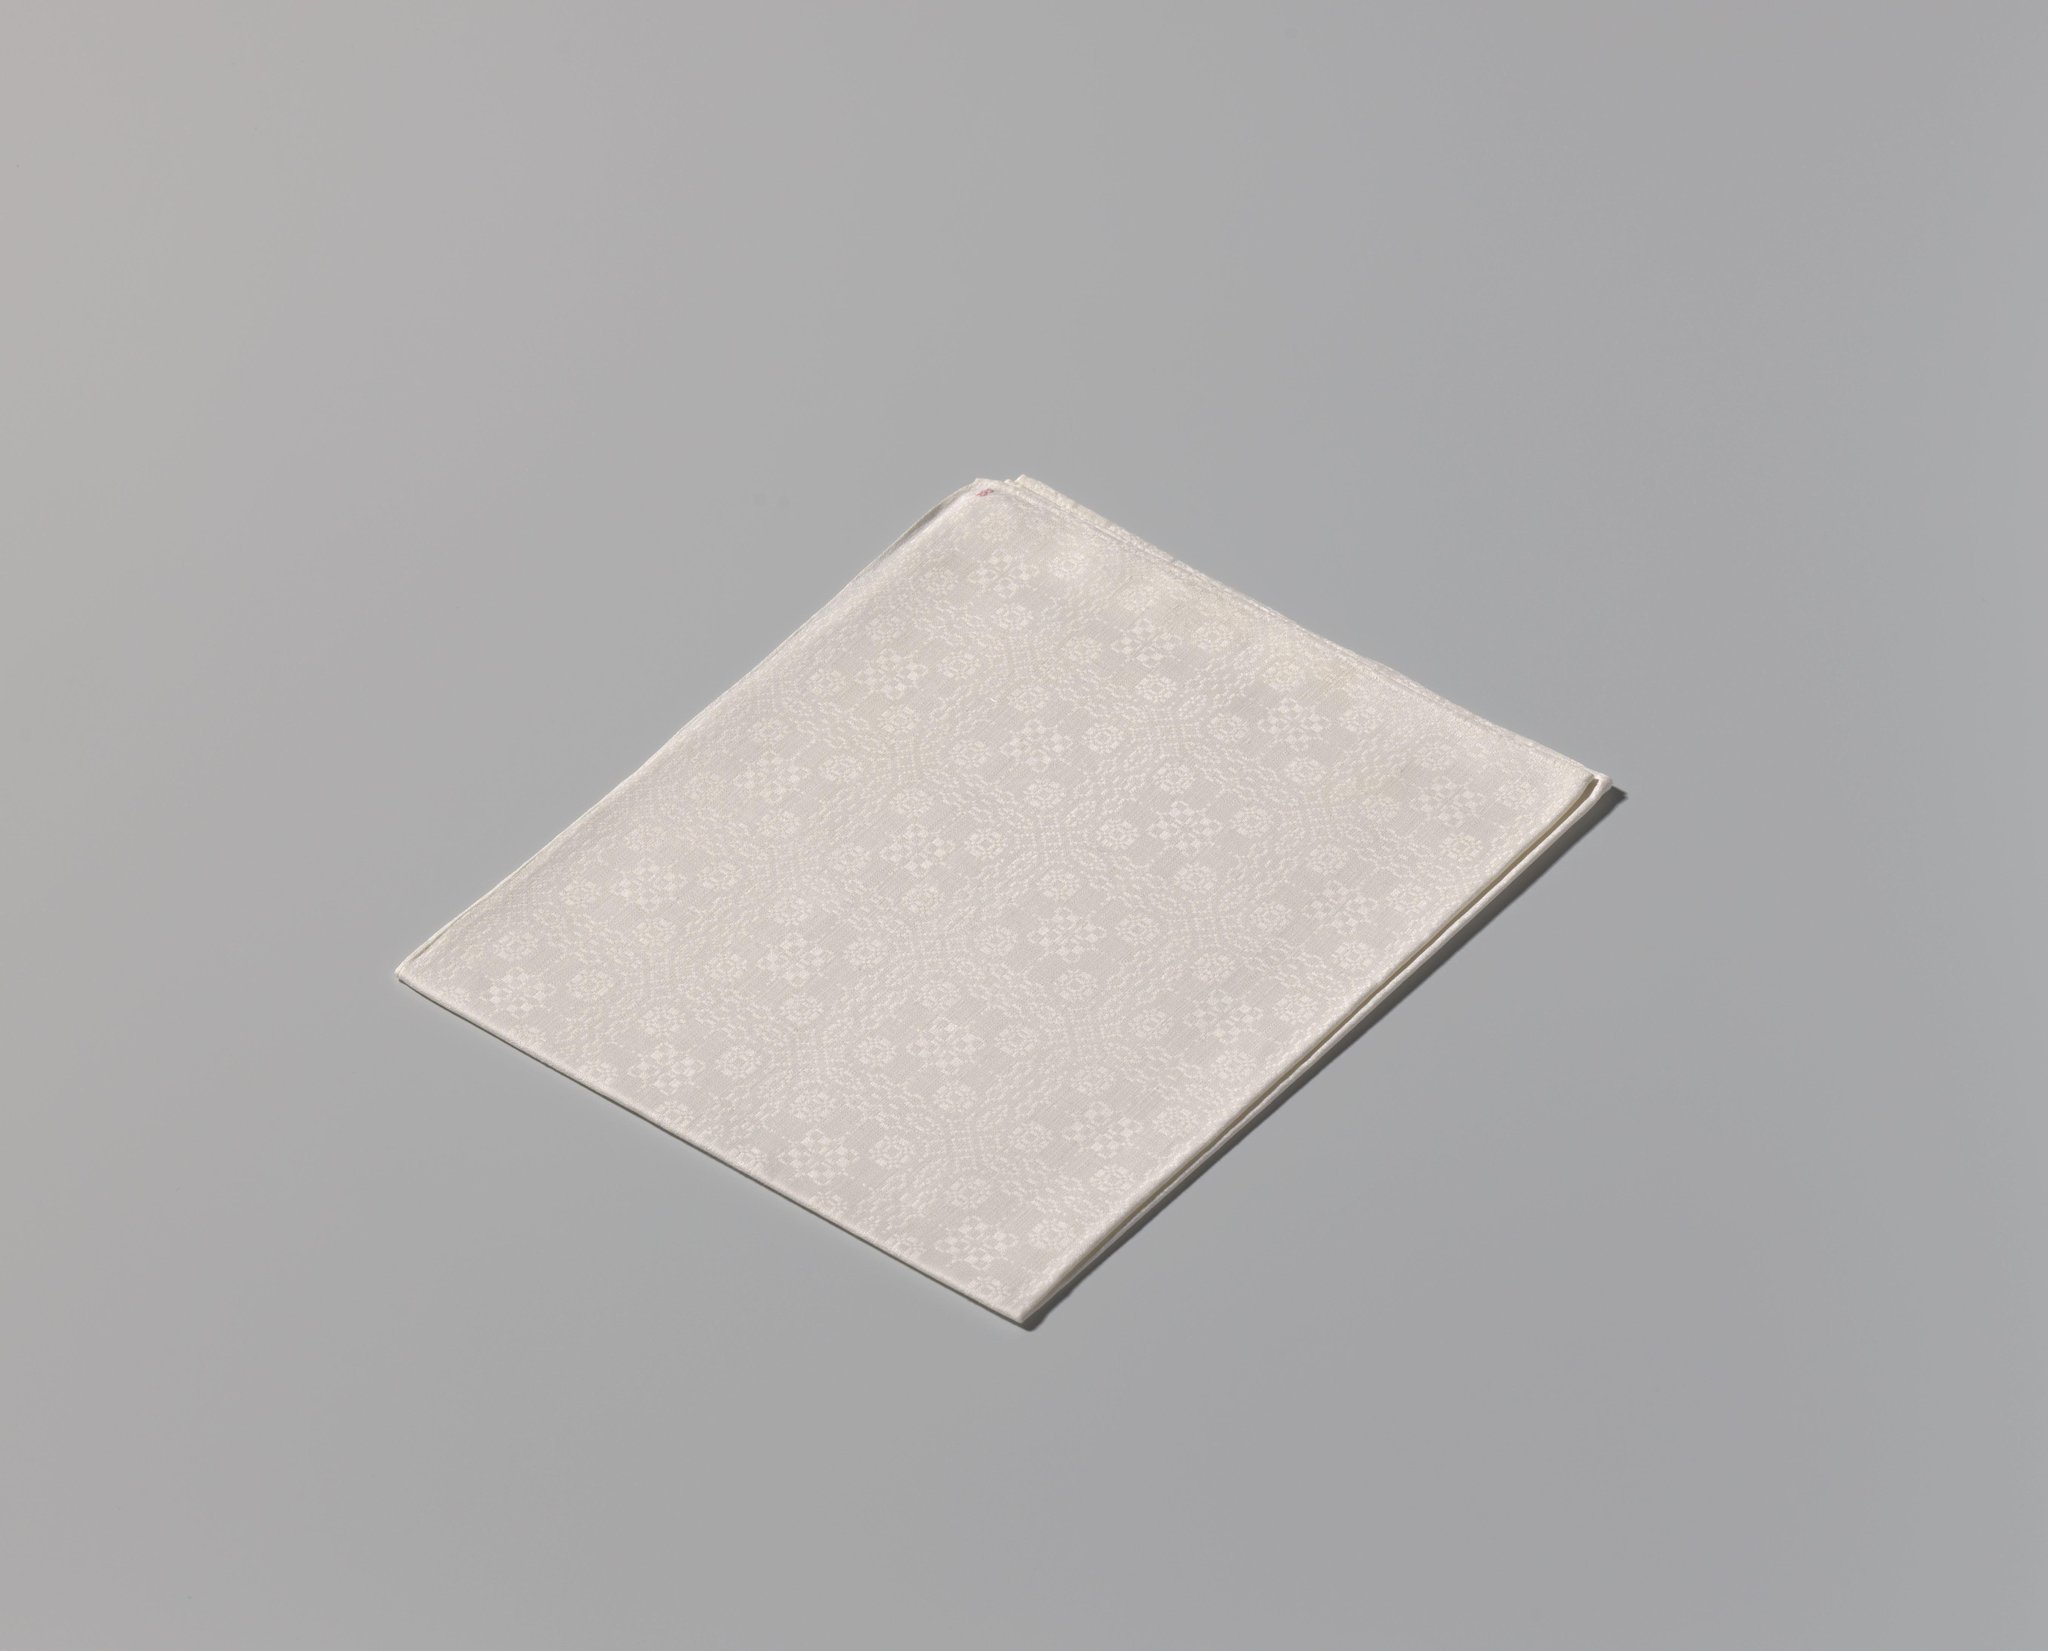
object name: napkin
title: Servet van pellendamast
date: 1675-1725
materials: linen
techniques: weave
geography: north brabant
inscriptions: mark: ‘B’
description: Servet van pellendamast. Elkaar snijdende rijen van ruiten vormen vierkanten, waarbinnen vijf blokken. Het servet is gehalveerd. Het servet hoort bij twaalf servetten en een tafellaken.